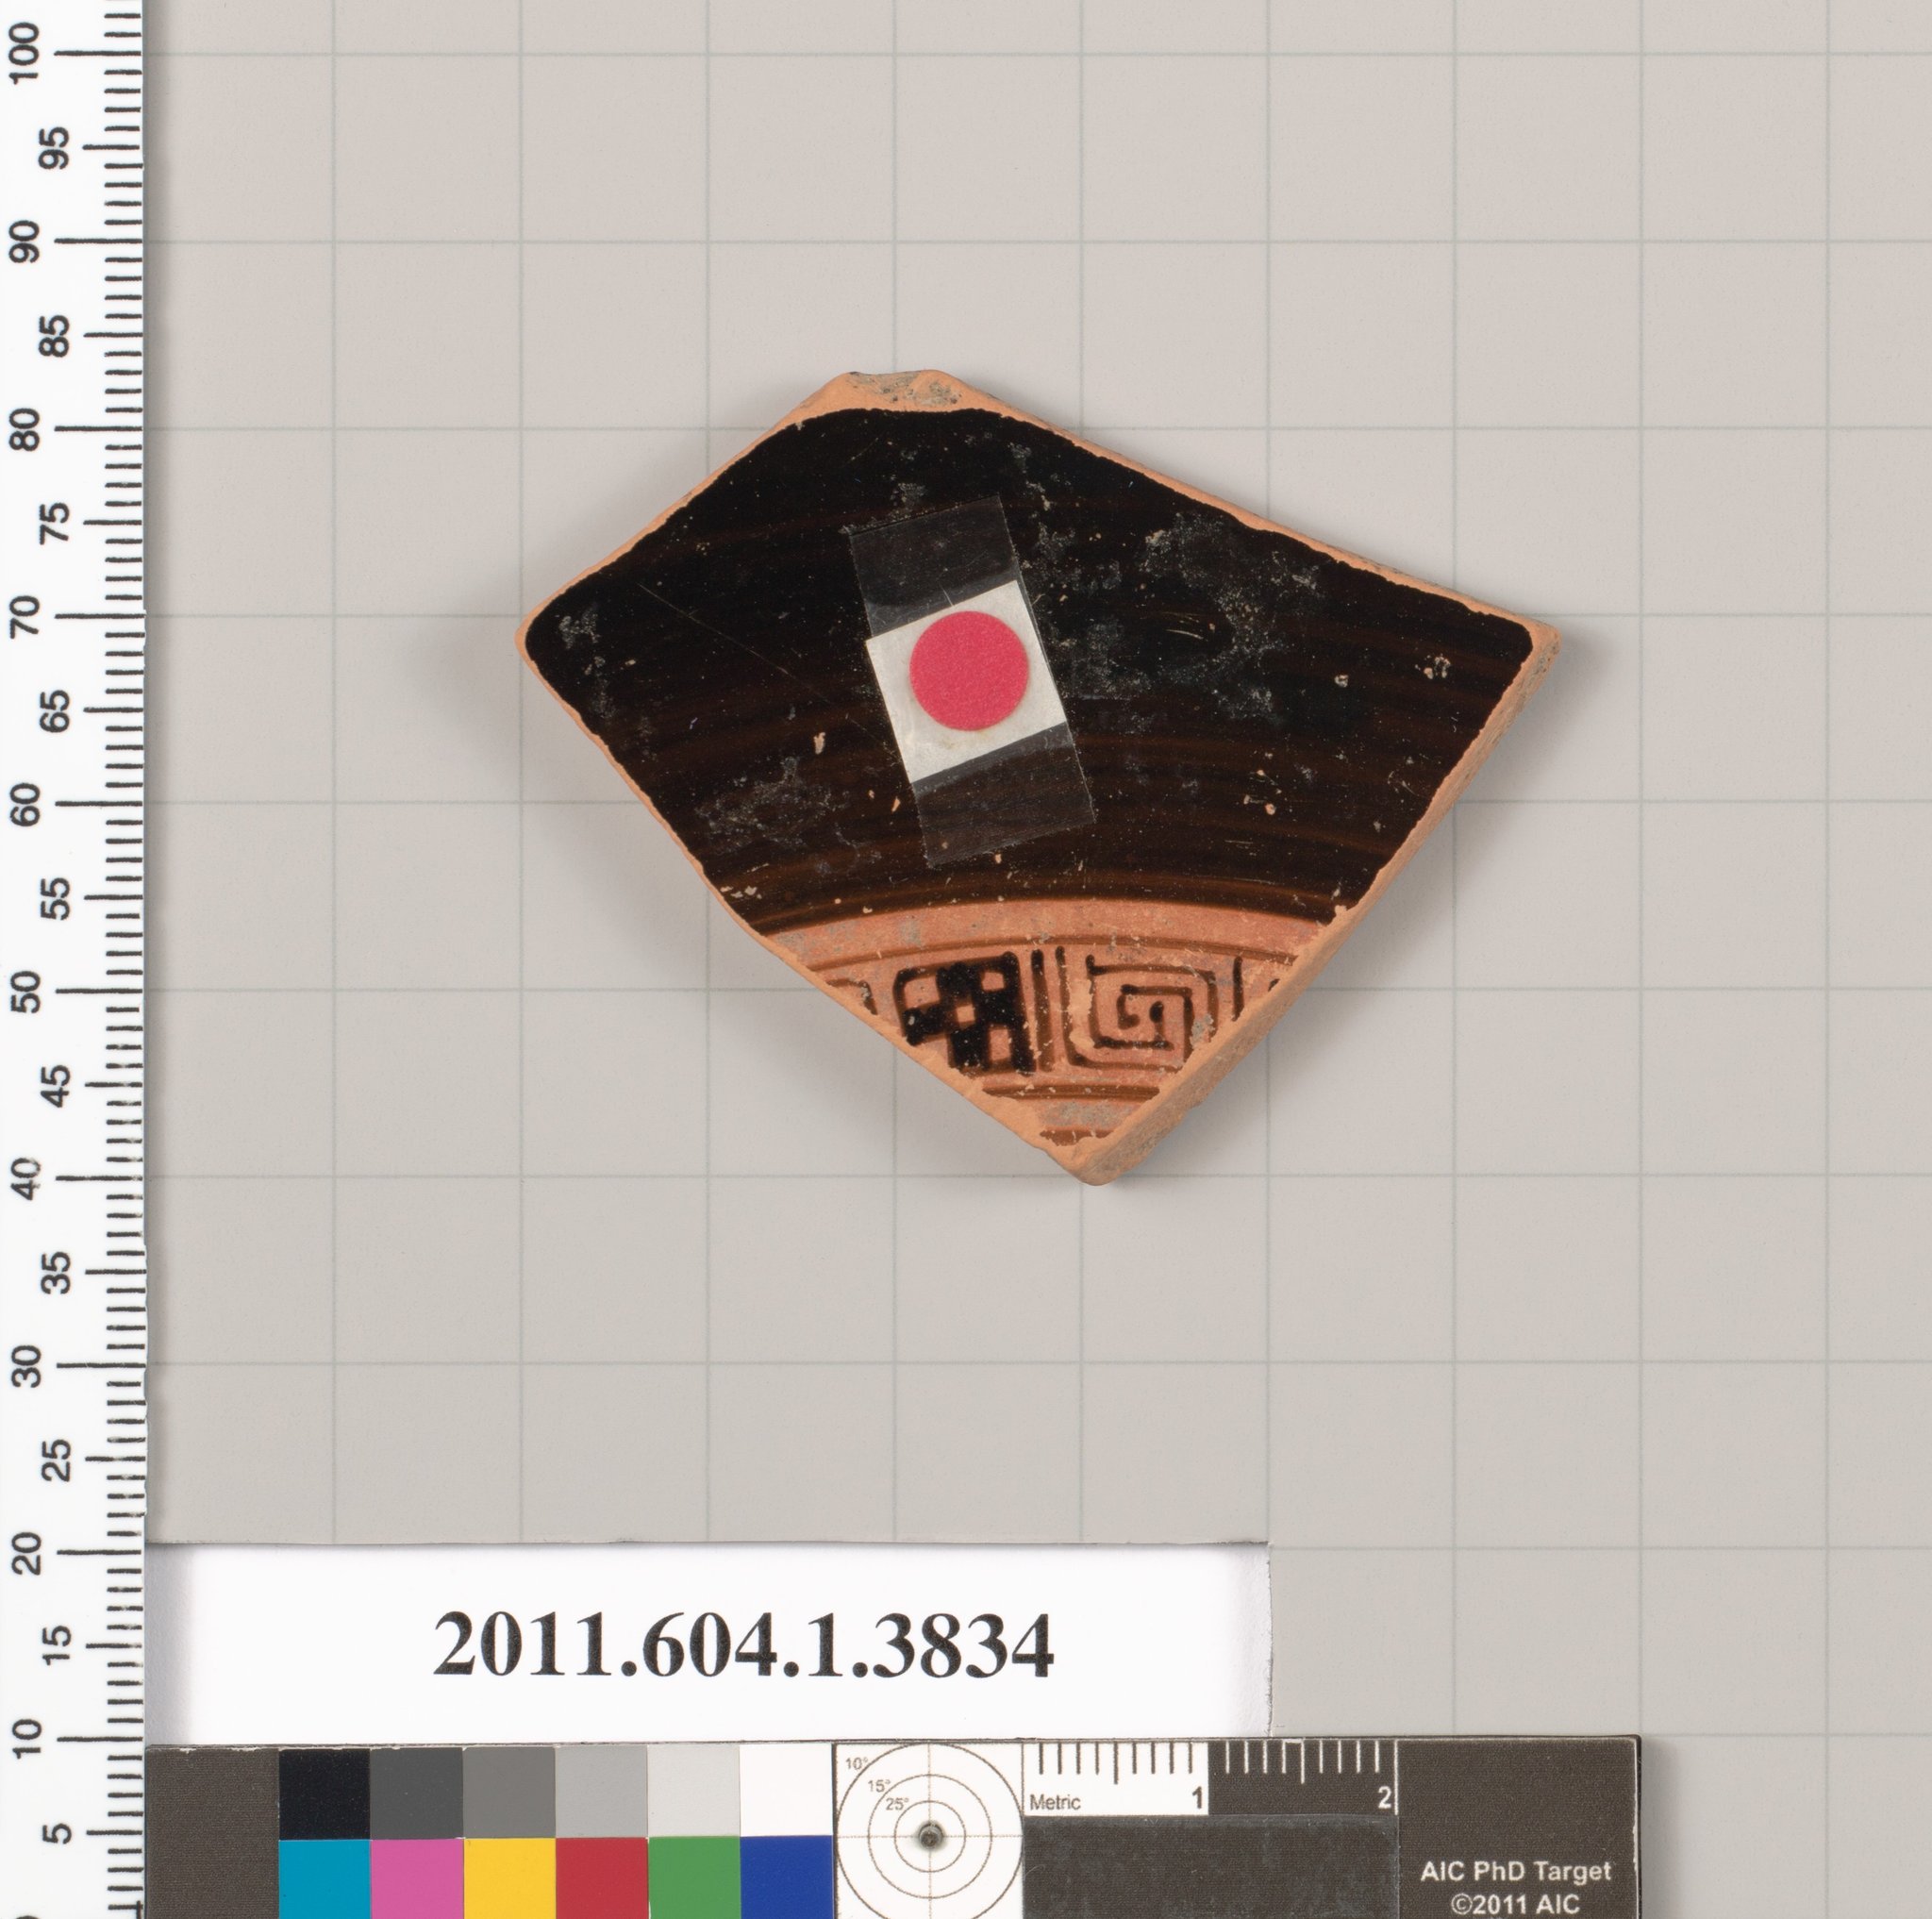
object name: kylix fragment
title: Terracotta fragment of a kylix (drinking cup)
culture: greek, attic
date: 475-451 BCE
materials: terracotta